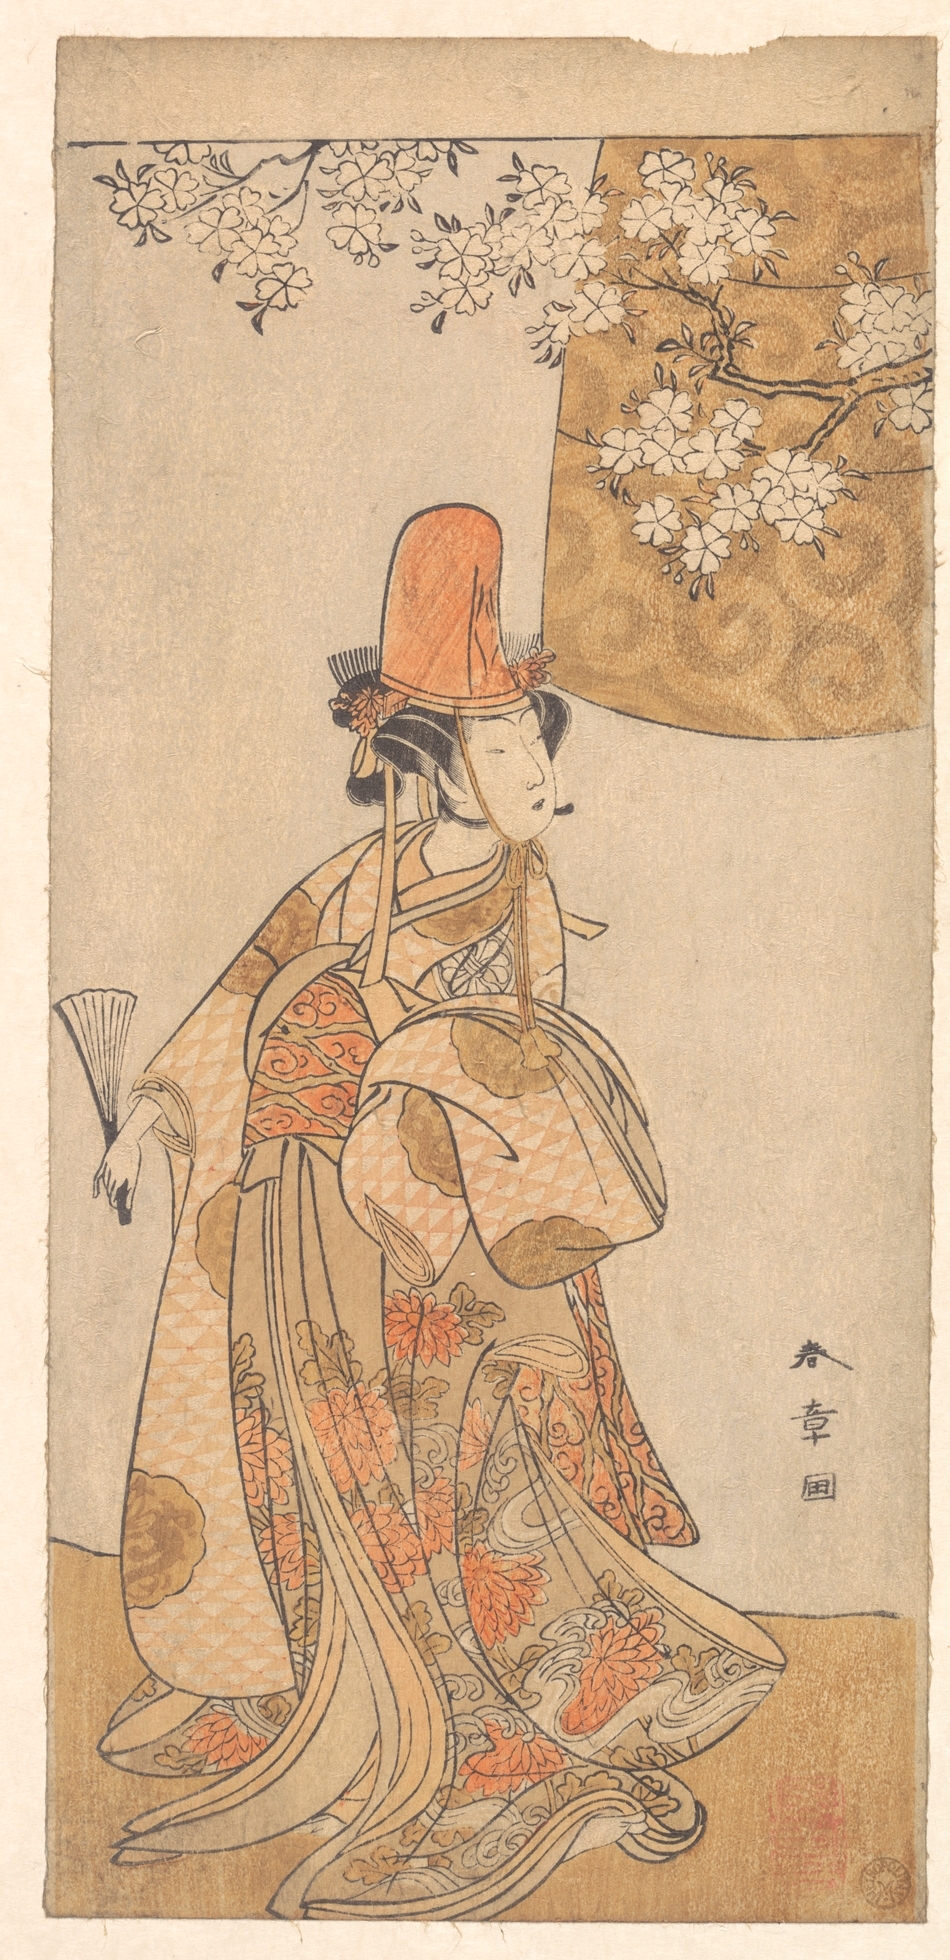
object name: woodblock print nishiki e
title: Segawa Tomisaburo in the Role of Musume Dojoji in "Hanagatami Kazaori Eboshi"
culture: japanese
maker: katsukawa shunshō 勝川春章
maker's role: artist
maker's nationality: japanese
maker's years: 1726-1792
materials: ink, paper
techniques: nishiki e, woodblock print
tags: fans,men,flowers,actors